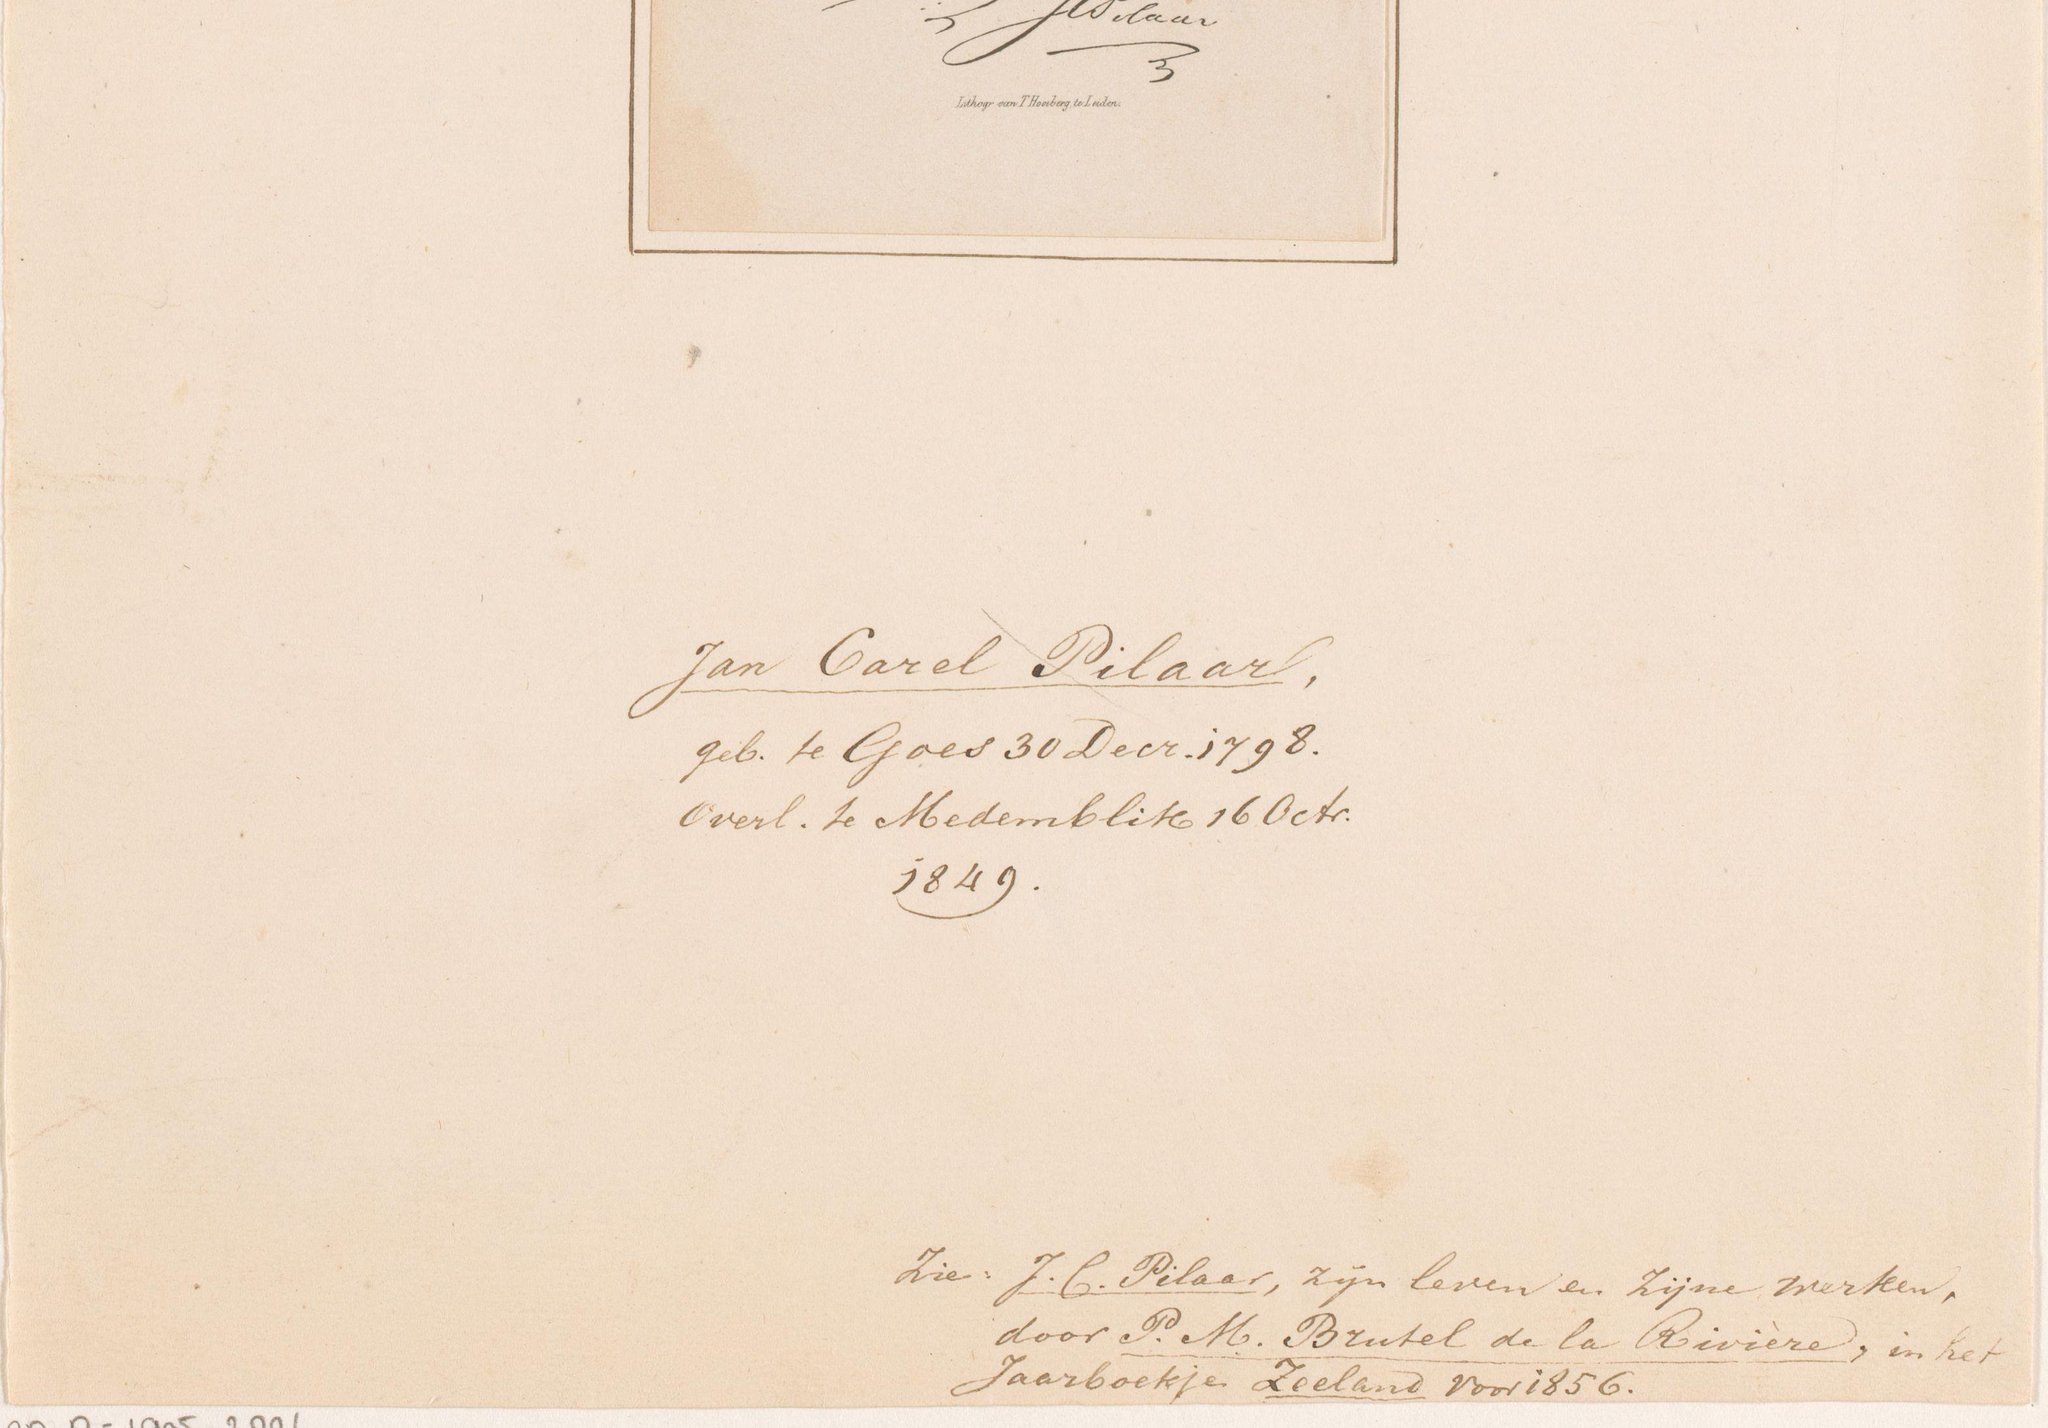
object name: print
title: Portret van Jan Carel Pilaar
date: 1819-1897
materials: paper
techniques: tone lithography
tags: knighthood order, historical persons (+ (full) bust portrait)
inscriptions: inscription: ‘Jan Carel Pilaar / geb. te Goes 30 decr. 1798 / overl. te Medemblik 16 octr. / 1849’ Lugt, inscription: ‘Zie: J. C. Pilaar, zijn leven en zijne werken, / door P. M. Brutel de la Rivièra, in het / Jaarboekje Zeeland voor 1856’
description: De geportretteerde draagt een jas met epauletten en een ridderorde. Zijn linkerhand heeft hij in zijn jas gestoken. Onder het portret zijn signatuur.